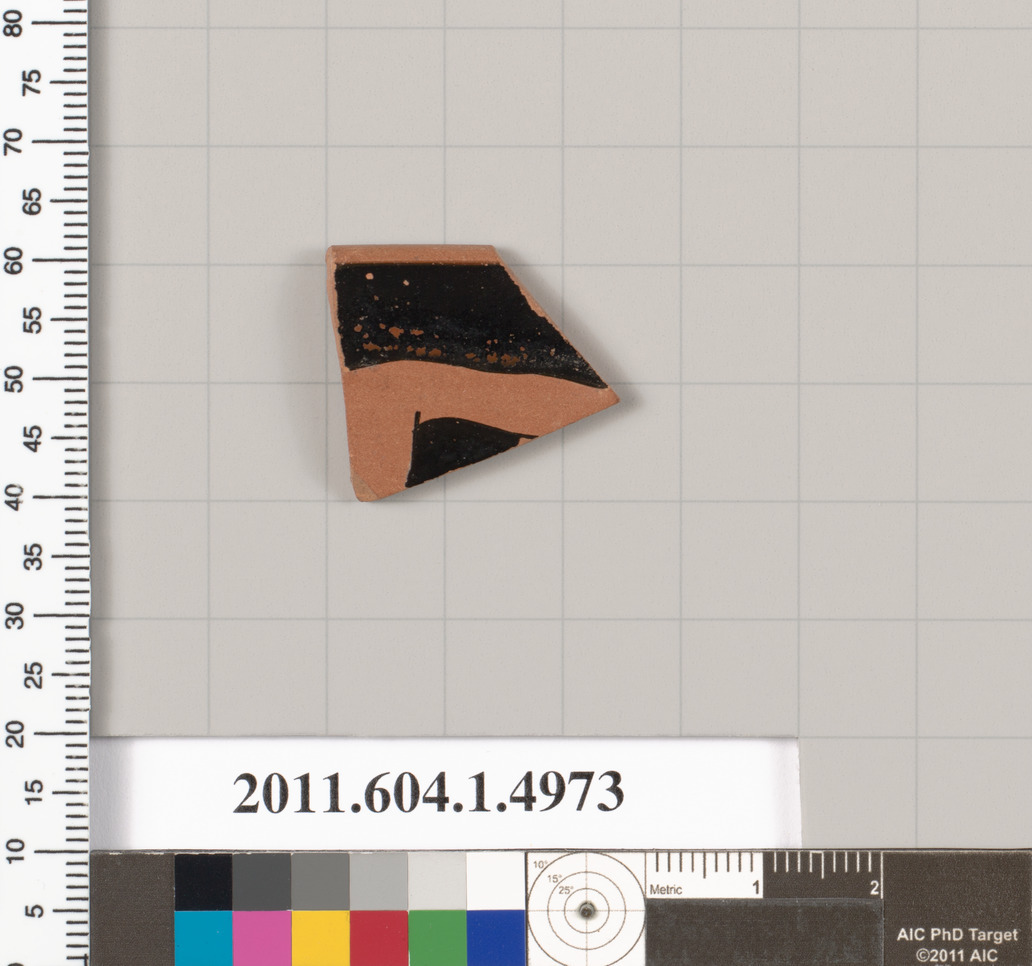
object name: kylix fragment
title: Terracotta rim fragment of a kylix (drinking cup)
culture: greek, attic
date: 490-480 BCE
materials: terracotta